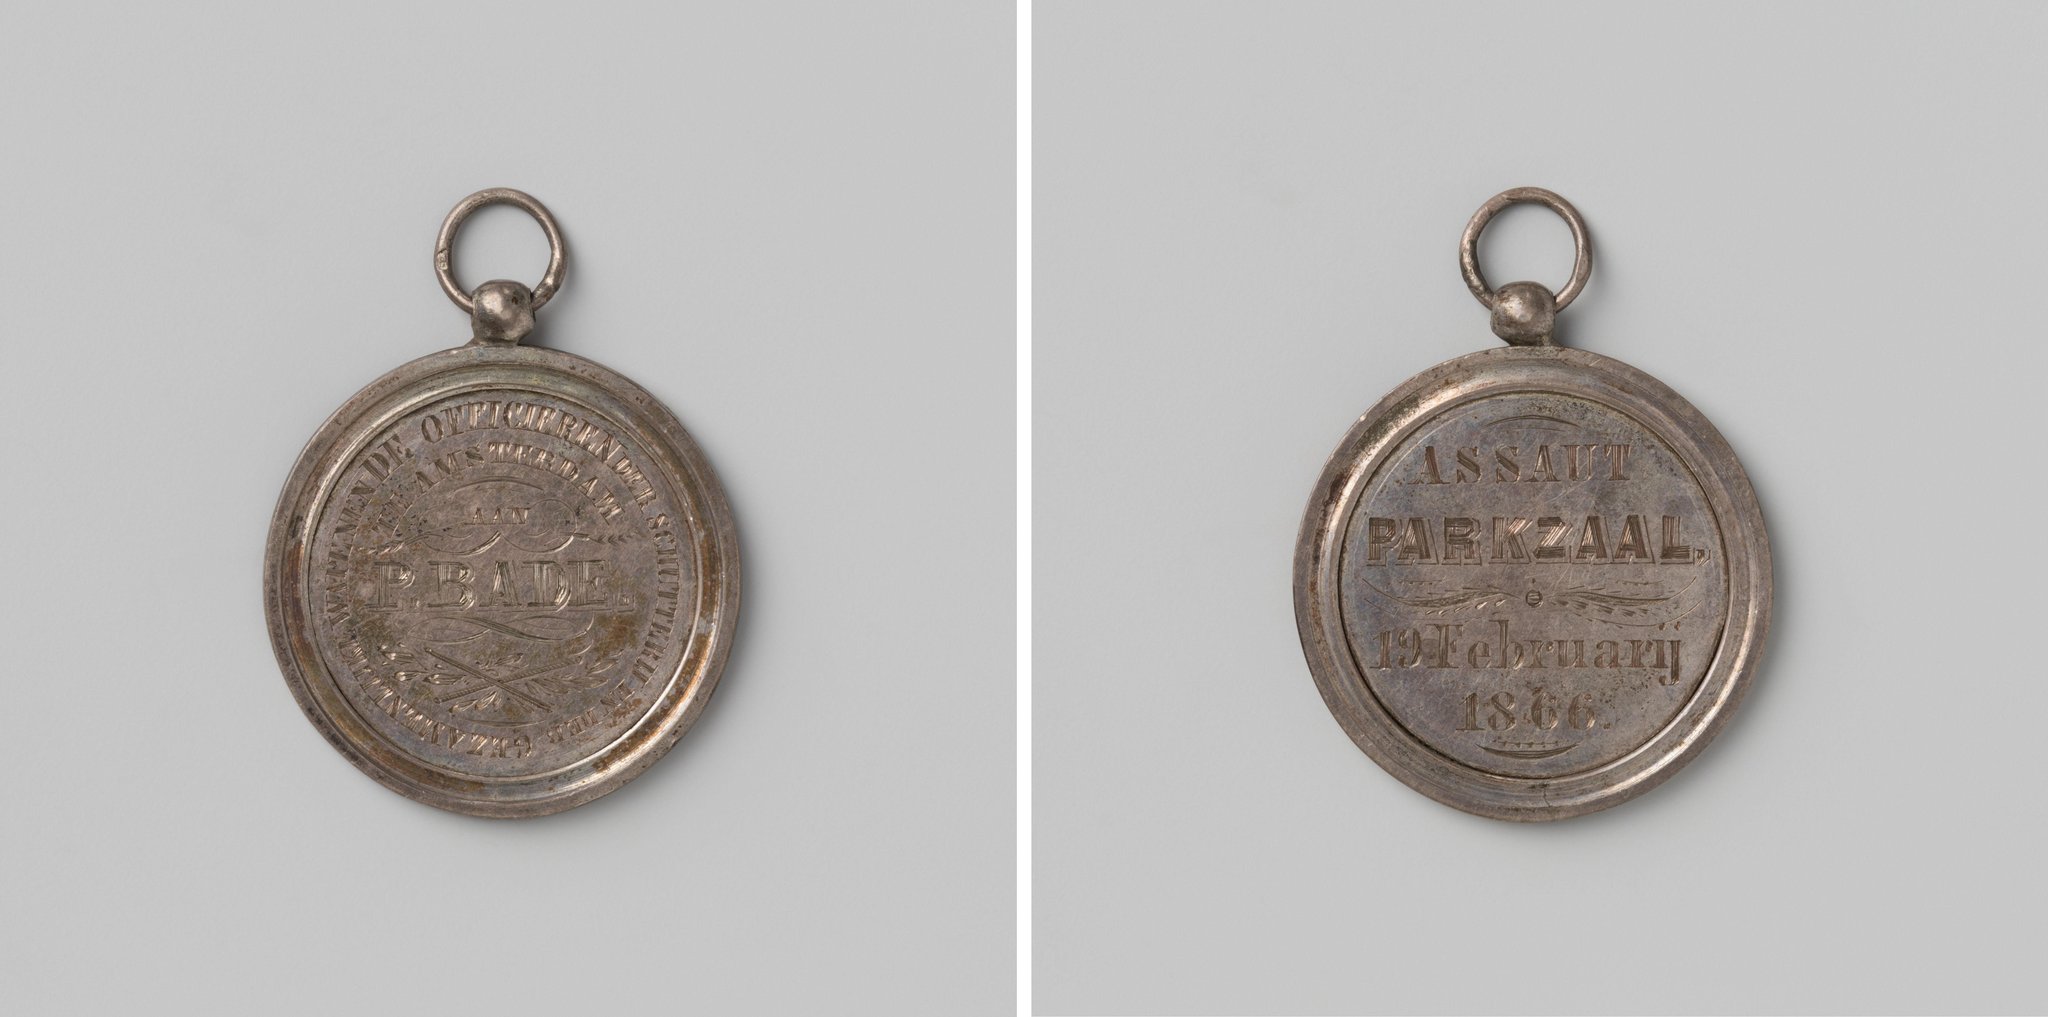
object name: medal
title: Officieren der schutterij en der gezamenlijke wapenen, prijspenning uitgereikt aan P. Bade tijdens de assaut in de Parkzaal te Amsterdam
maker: Anonymous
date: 1866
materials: silver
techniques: engraving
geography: amsterdam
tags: amsterdam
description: Zilveren penning aan draagoog en draagring. Voorzijde: opschrift. Keerzijde: opschrift binnen omschrift.